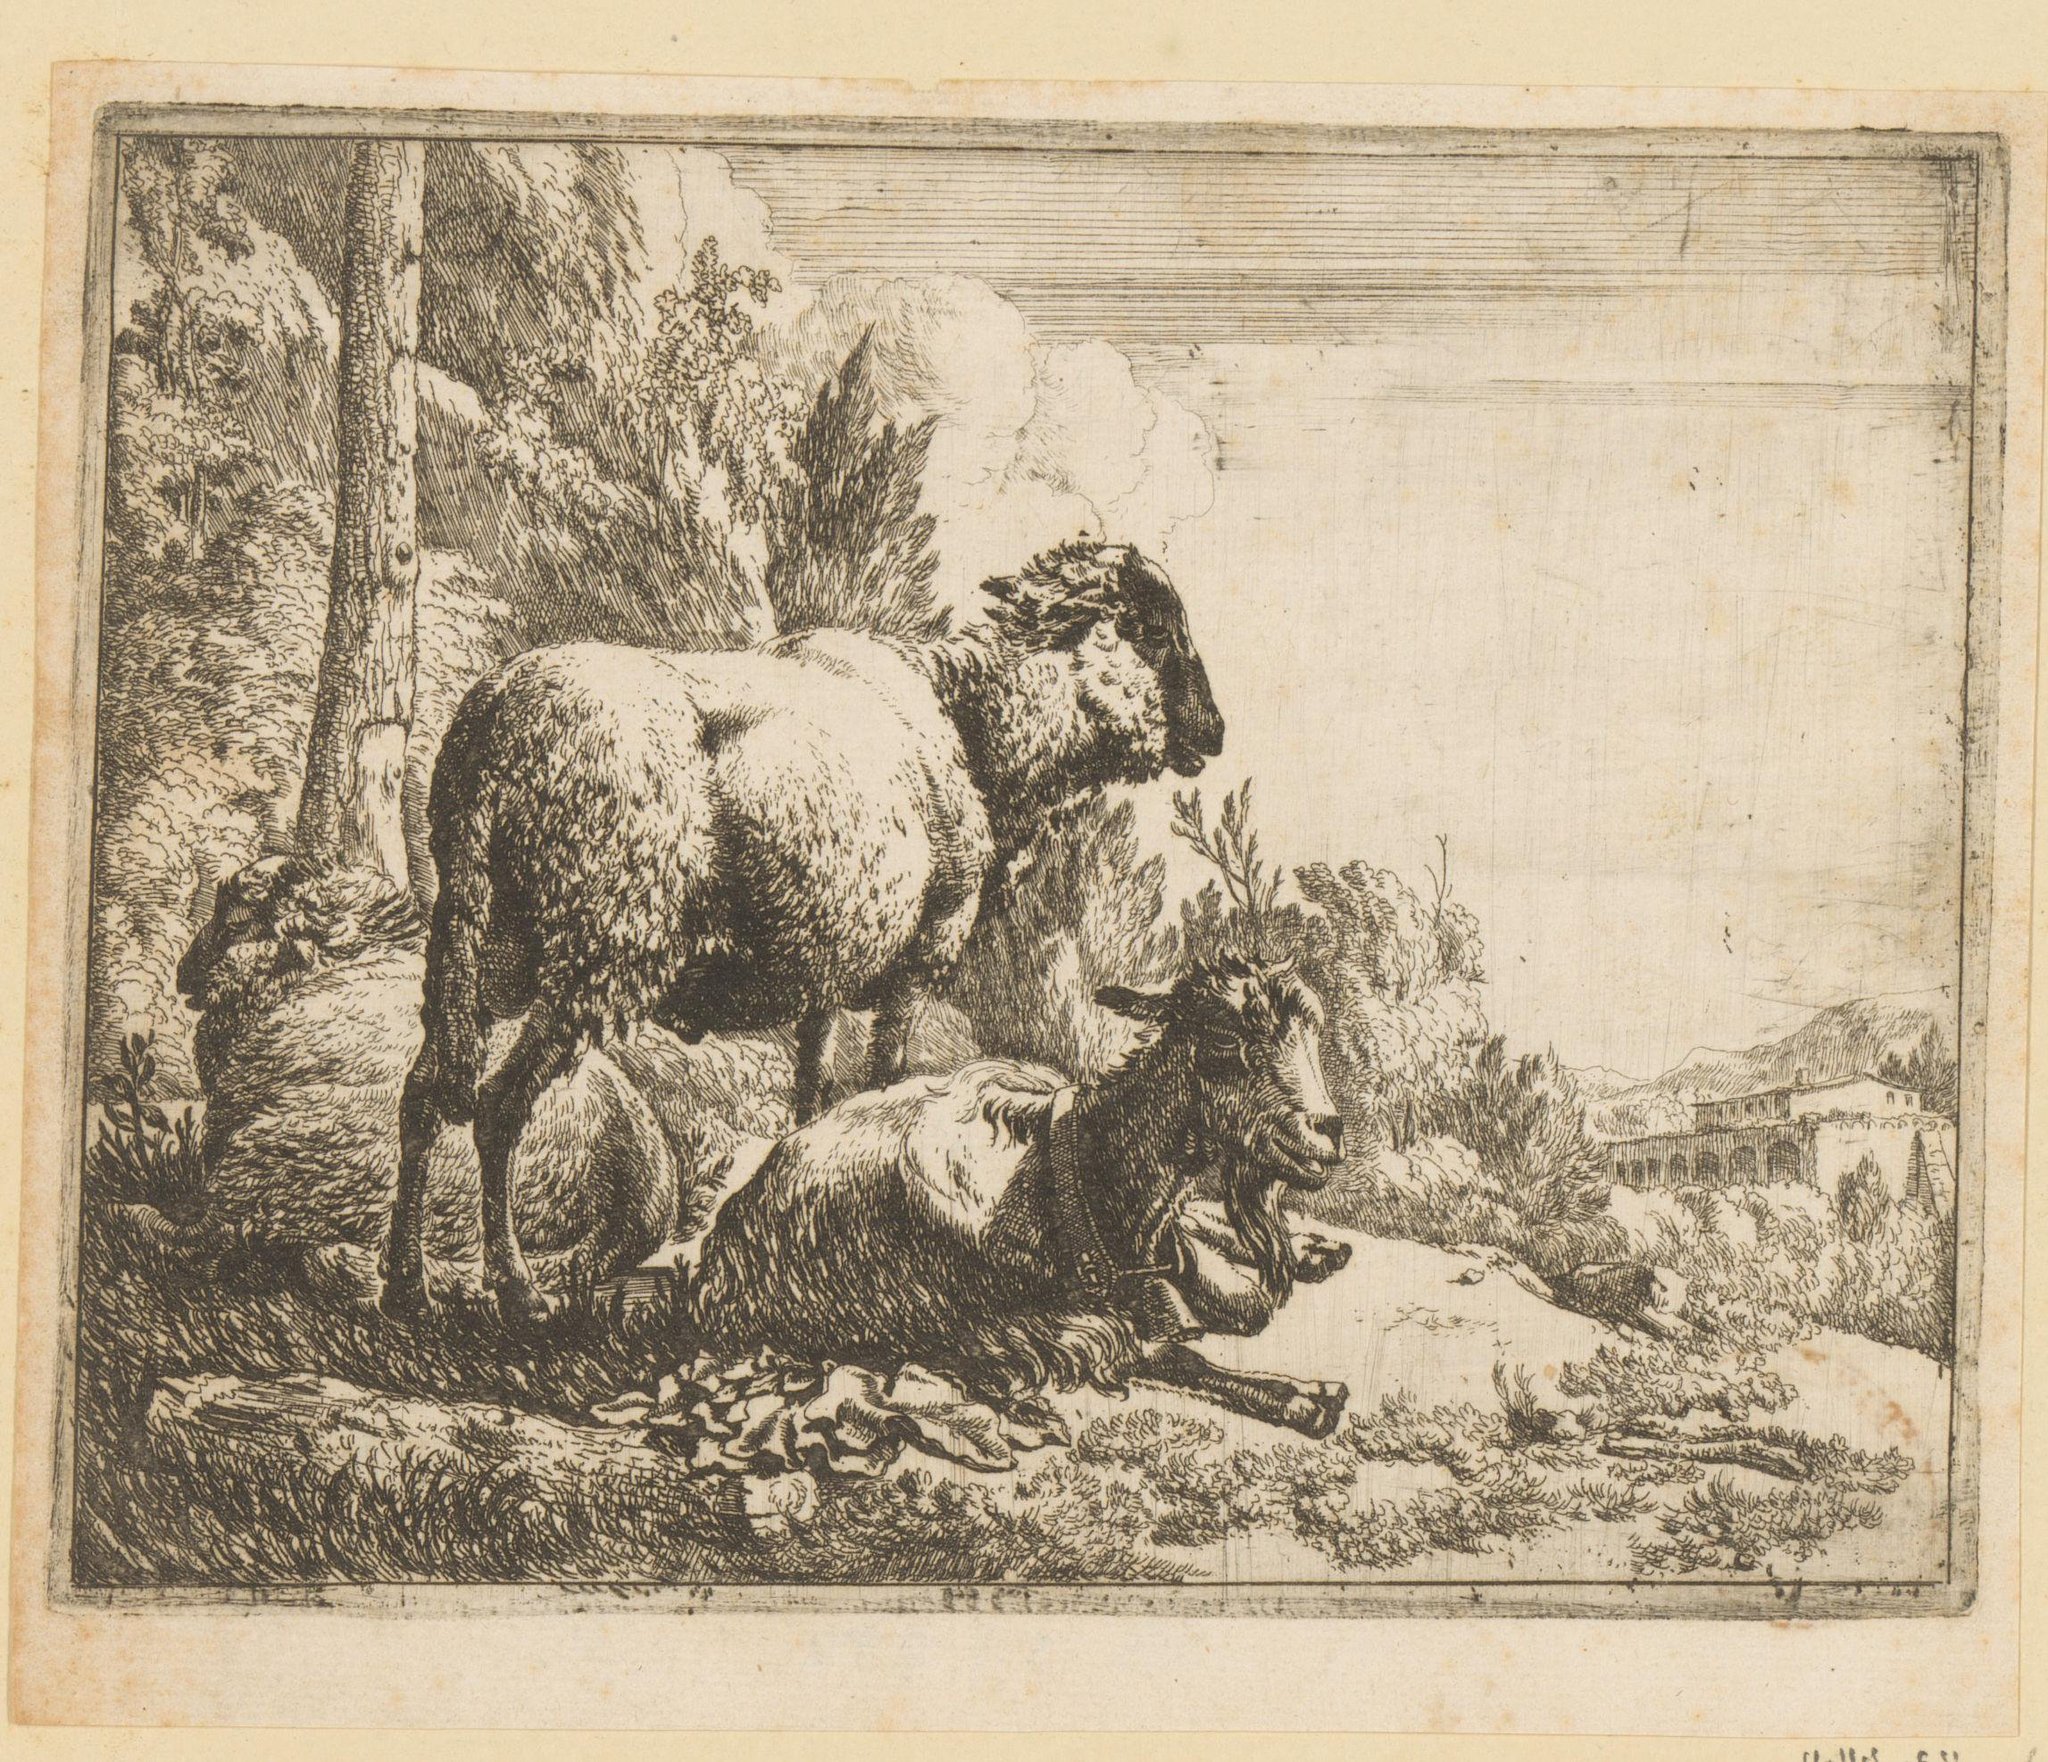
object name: print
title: Schapen en geiten bij ruïnes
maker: johann heinrich roos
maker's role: draughtsman, print maker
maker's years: 1631-1685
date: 1665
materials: paper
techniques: engraving, etching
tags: landscape with ruins, sheep, goat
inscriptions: collector's mark: Lugt 240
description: Serie van acht prenten, waarvan één titelprent.